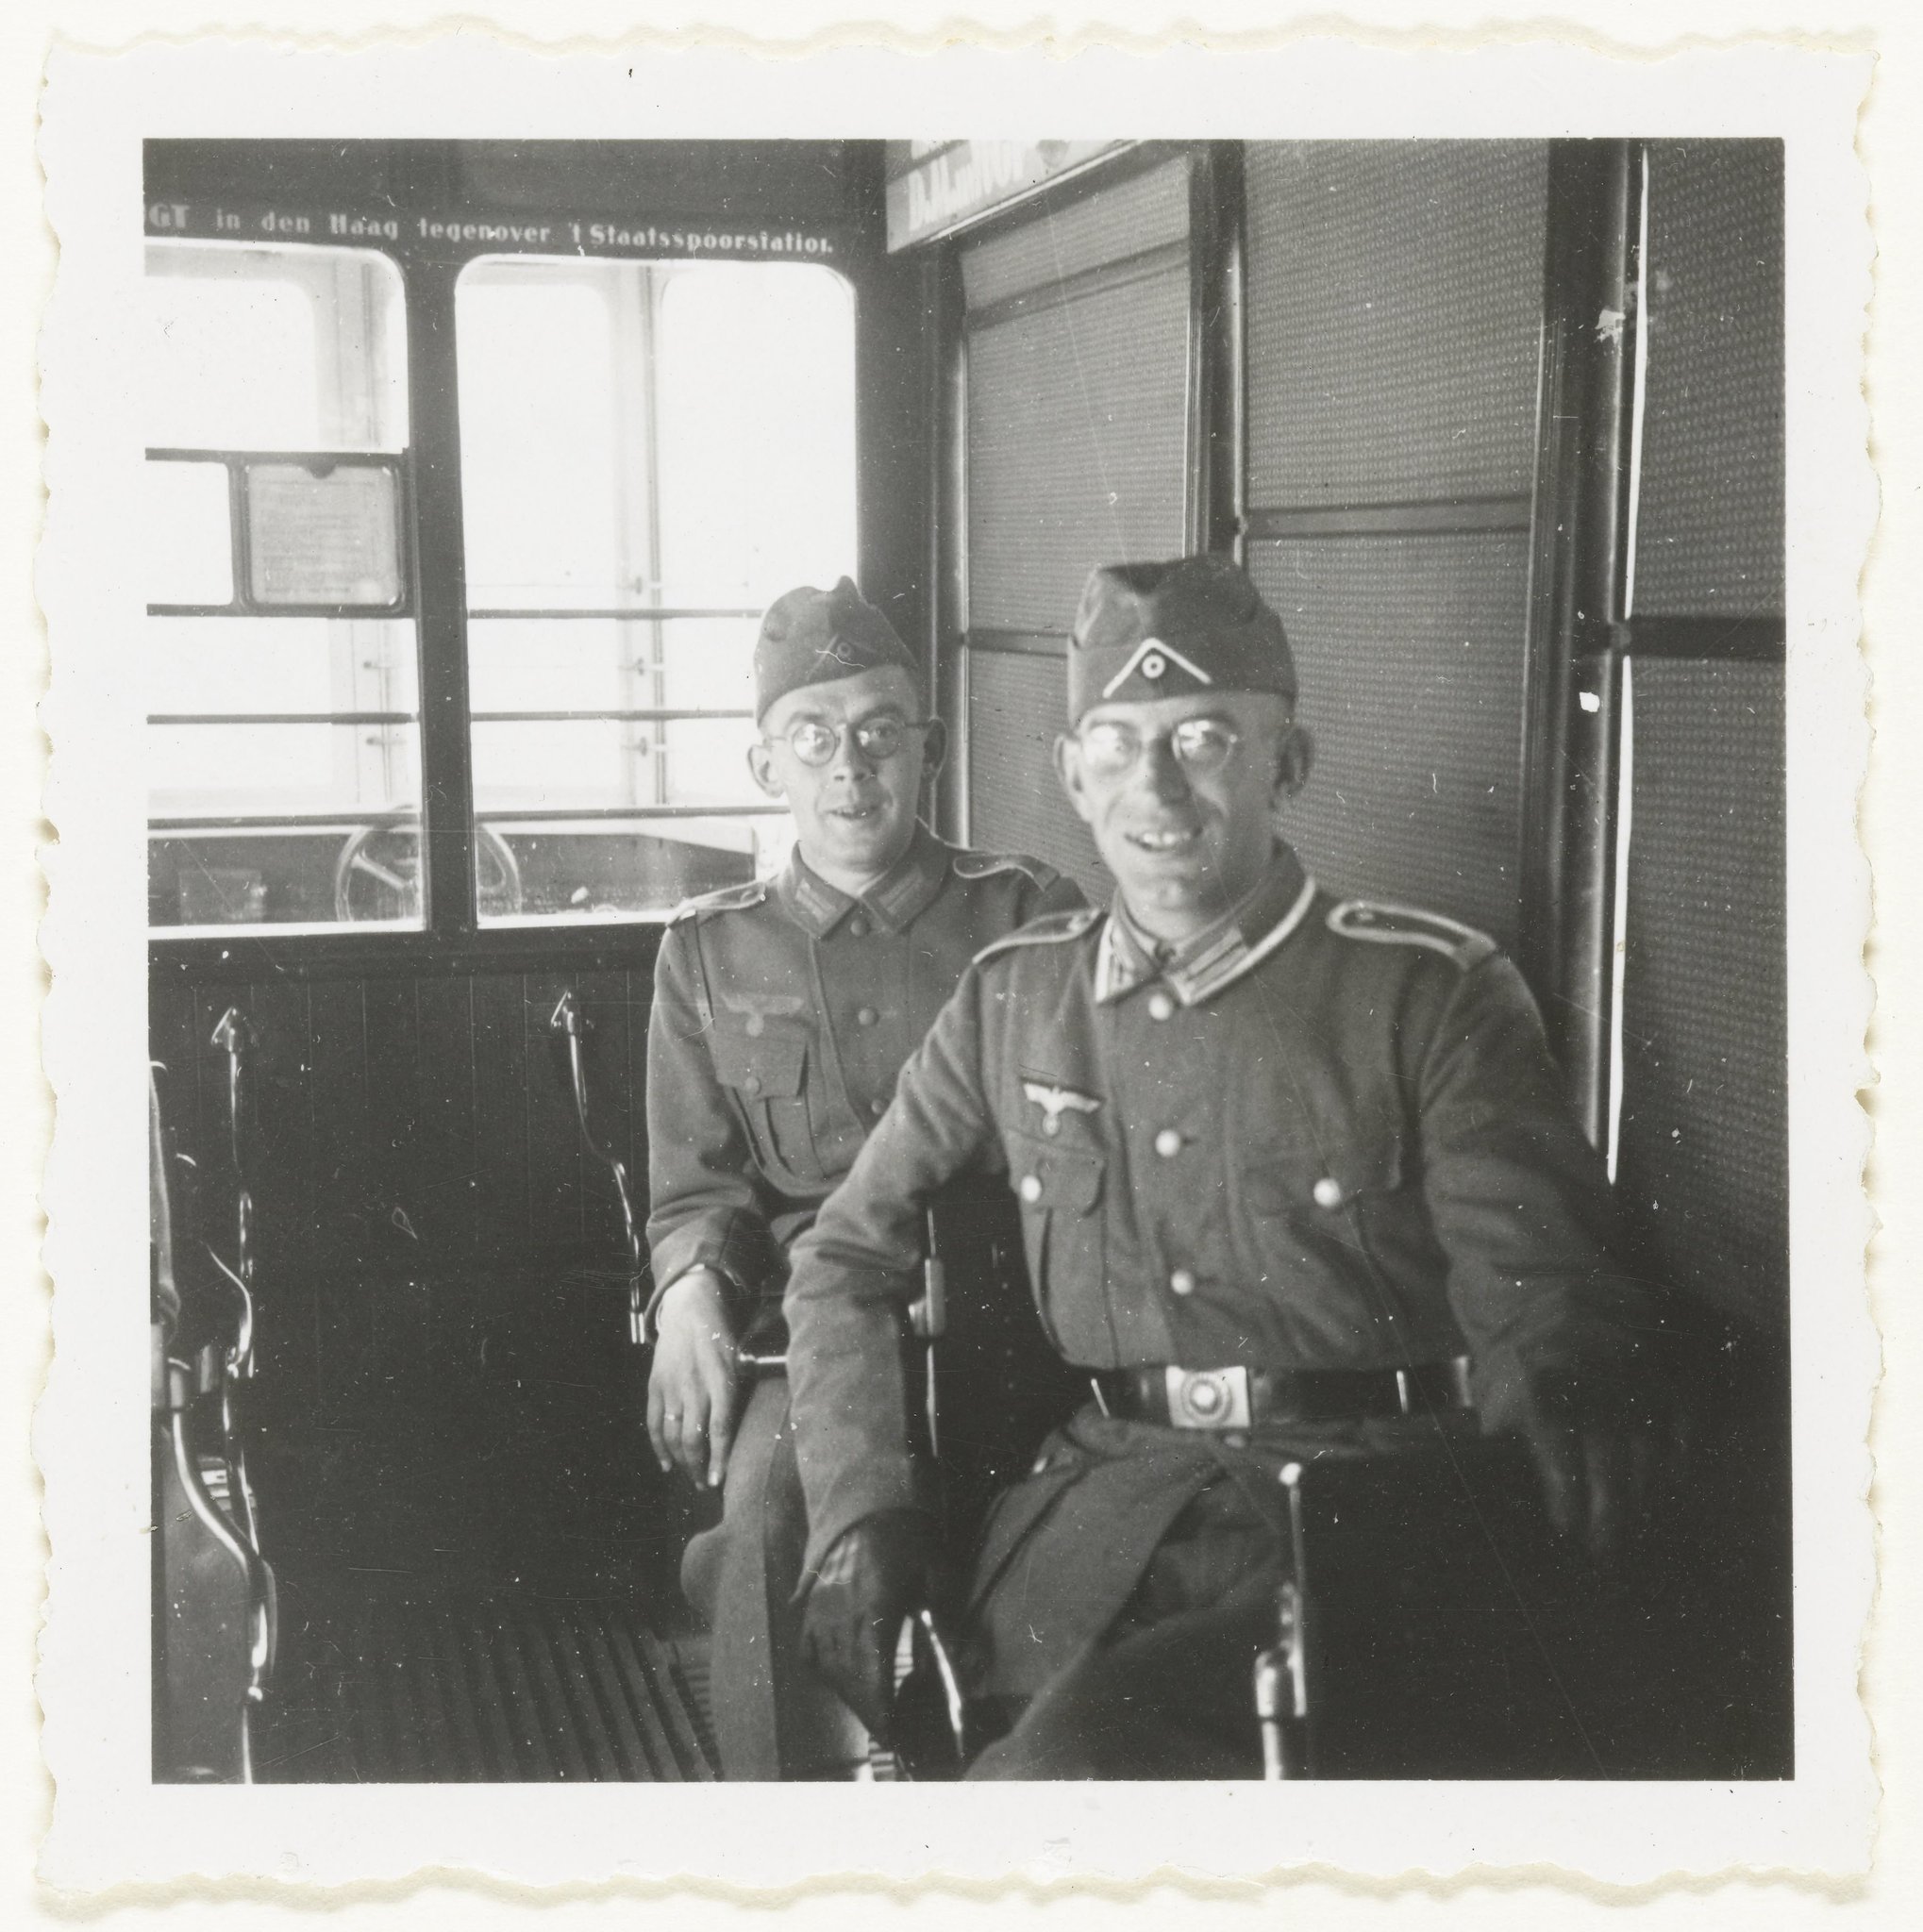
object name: photograph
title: Wehrmacht soldaten in de tram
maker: Anonymous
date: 1941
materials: photographic support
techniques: gelatin silver print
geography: the hague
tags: railway, train, occupation ~ war, the hague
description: Twee Wehrmacht soldaten zitten in de tram. Beide dragen een bril. Achterop staat: In Holland. 15.5.41. In der Tram von Den Haag nach Scheveningen